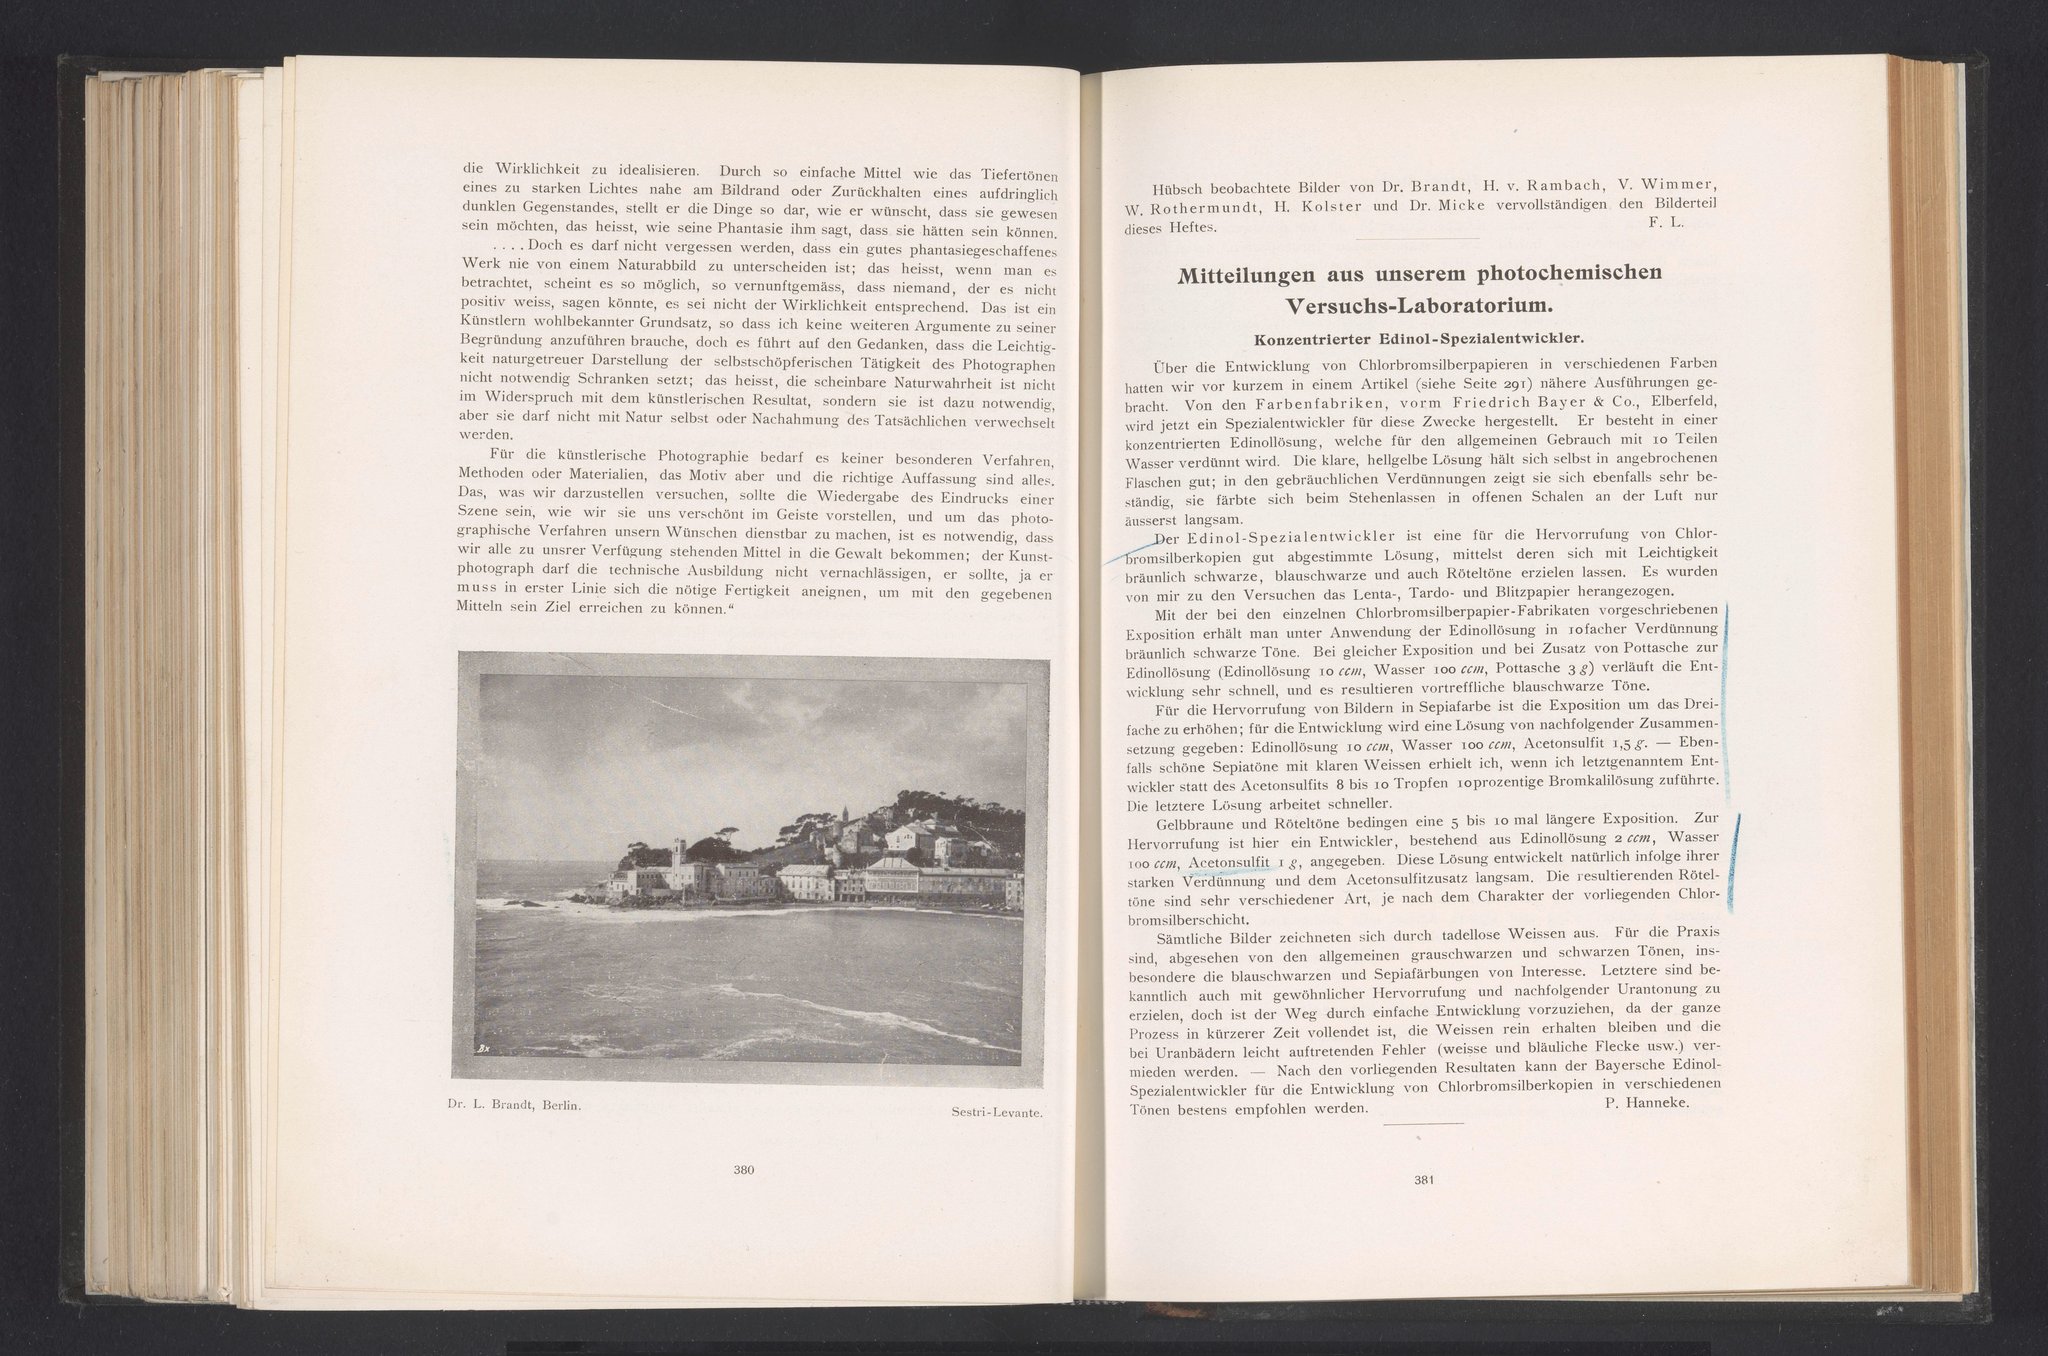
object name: photomechanical print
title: Gezicht op Sestri Levante en de Ligurische Zee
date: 1898-1903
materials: paper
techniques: autotype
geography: sestri levante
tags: city-view in general; 'veduta', sea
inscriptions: monogram: ‘BX’